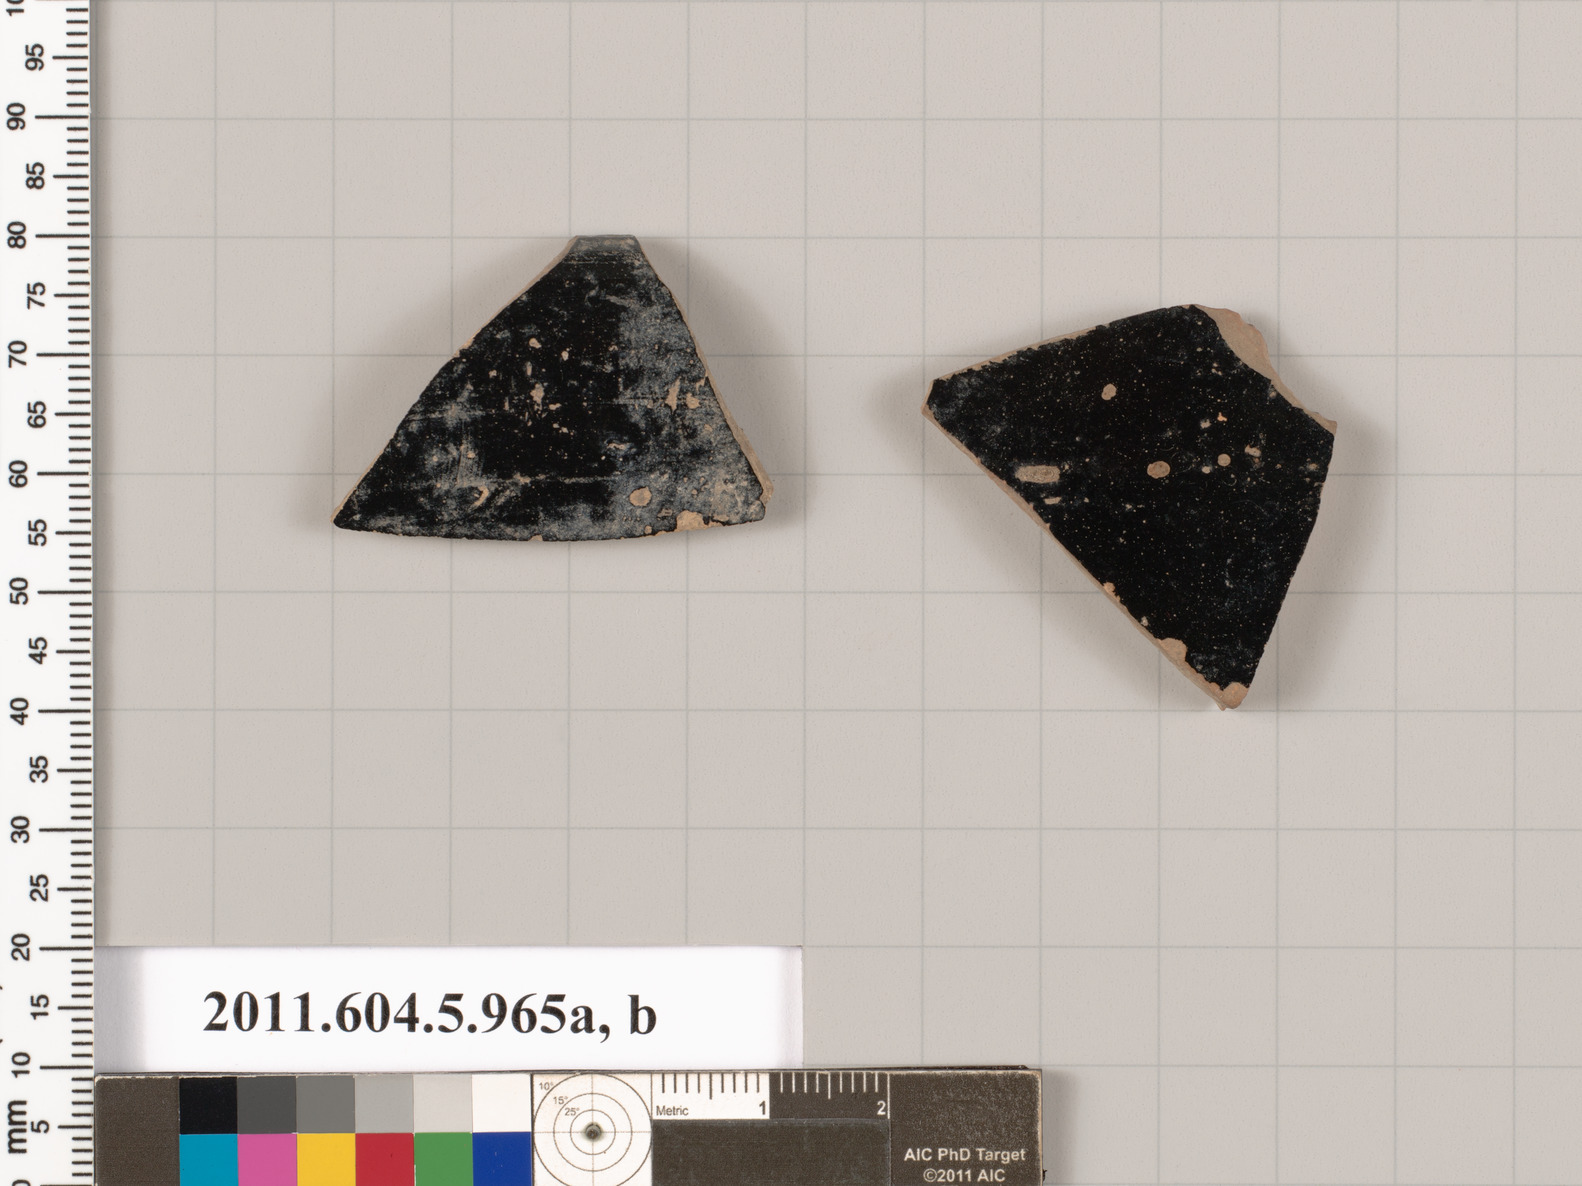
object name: kylix fragment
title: Terracotta fragments of a kylix (drinking cup)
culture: greek, attic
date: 600-401 BCE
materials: terracotta